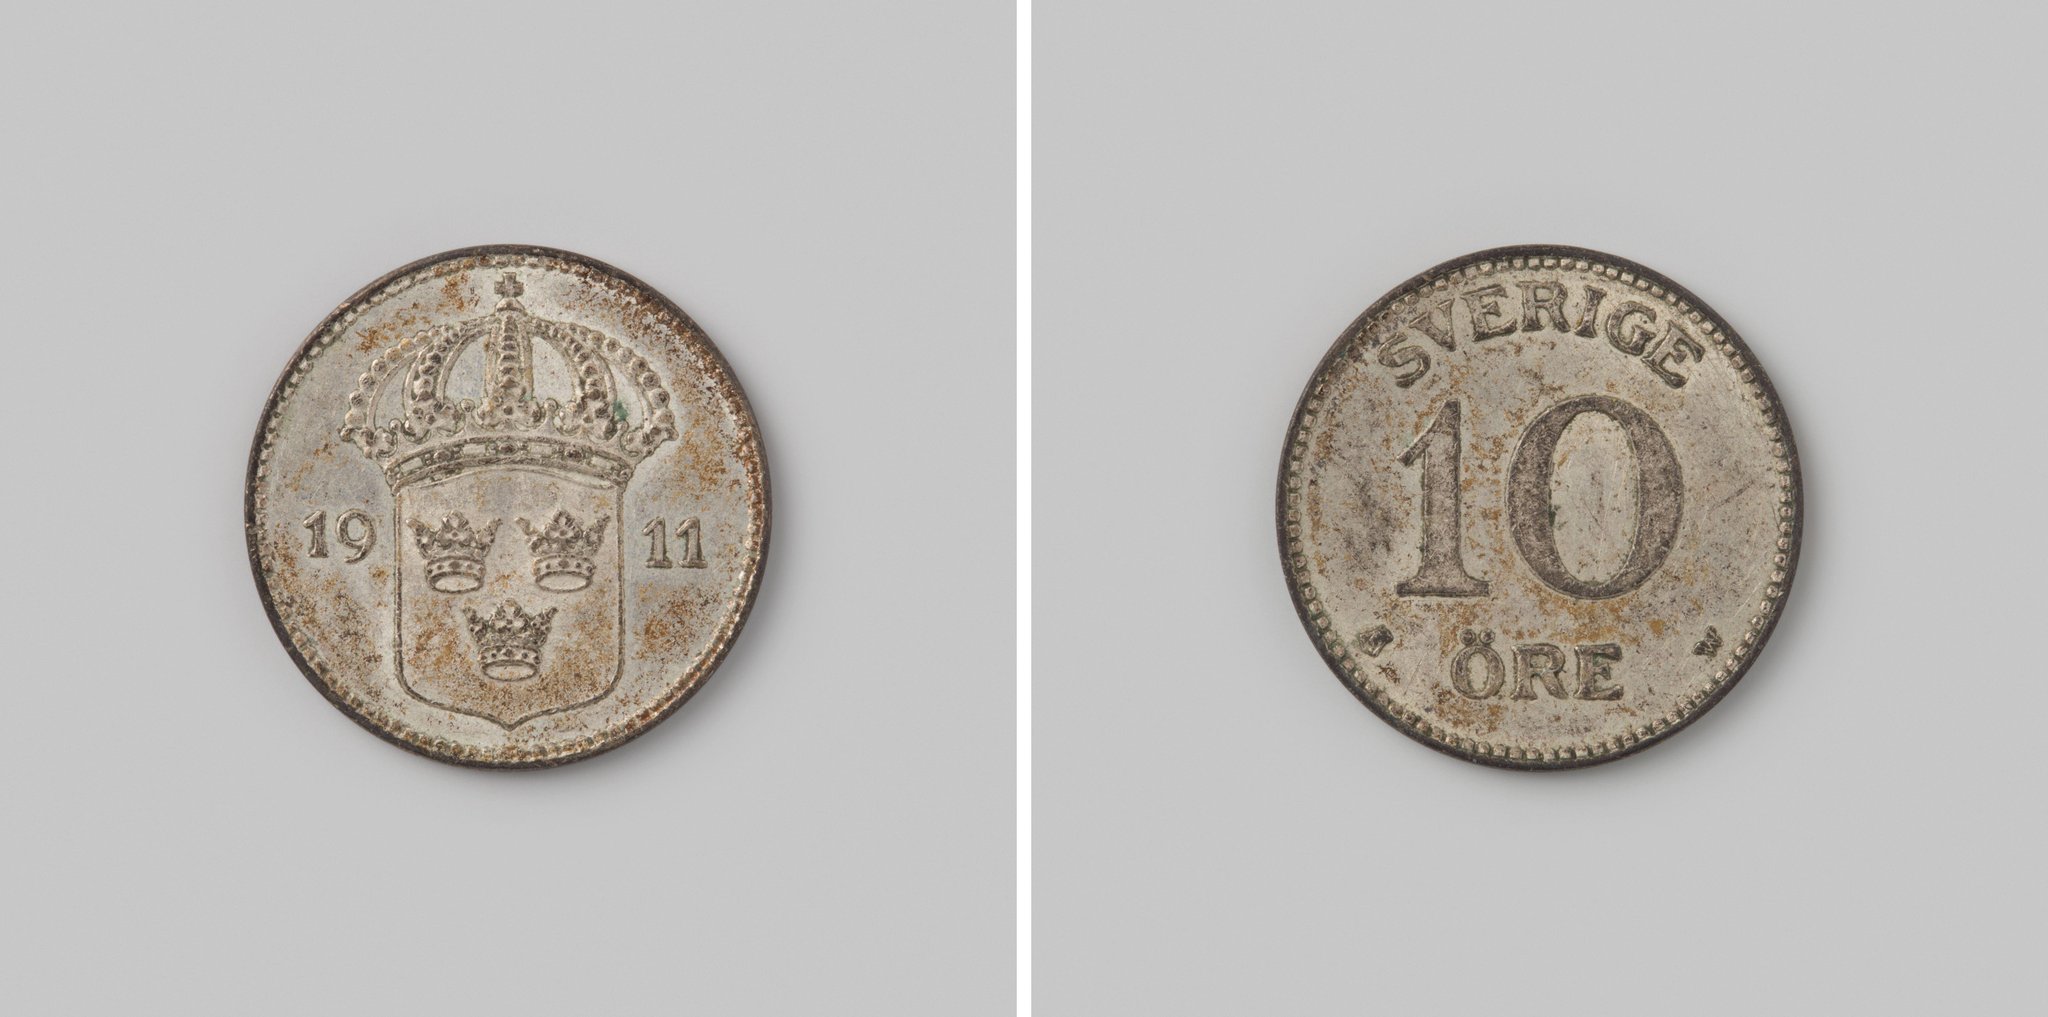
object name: coin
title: 10 öre uit Zweden van Gustaf V, 1911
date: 1911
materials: silver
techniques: striking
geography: slot rörstrand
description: Zilveren munt. Voorzijde: tussen jaartal gekroond wapenschild. Keerzijde: waarde-aanduiding in twee regels. Gladde rand.